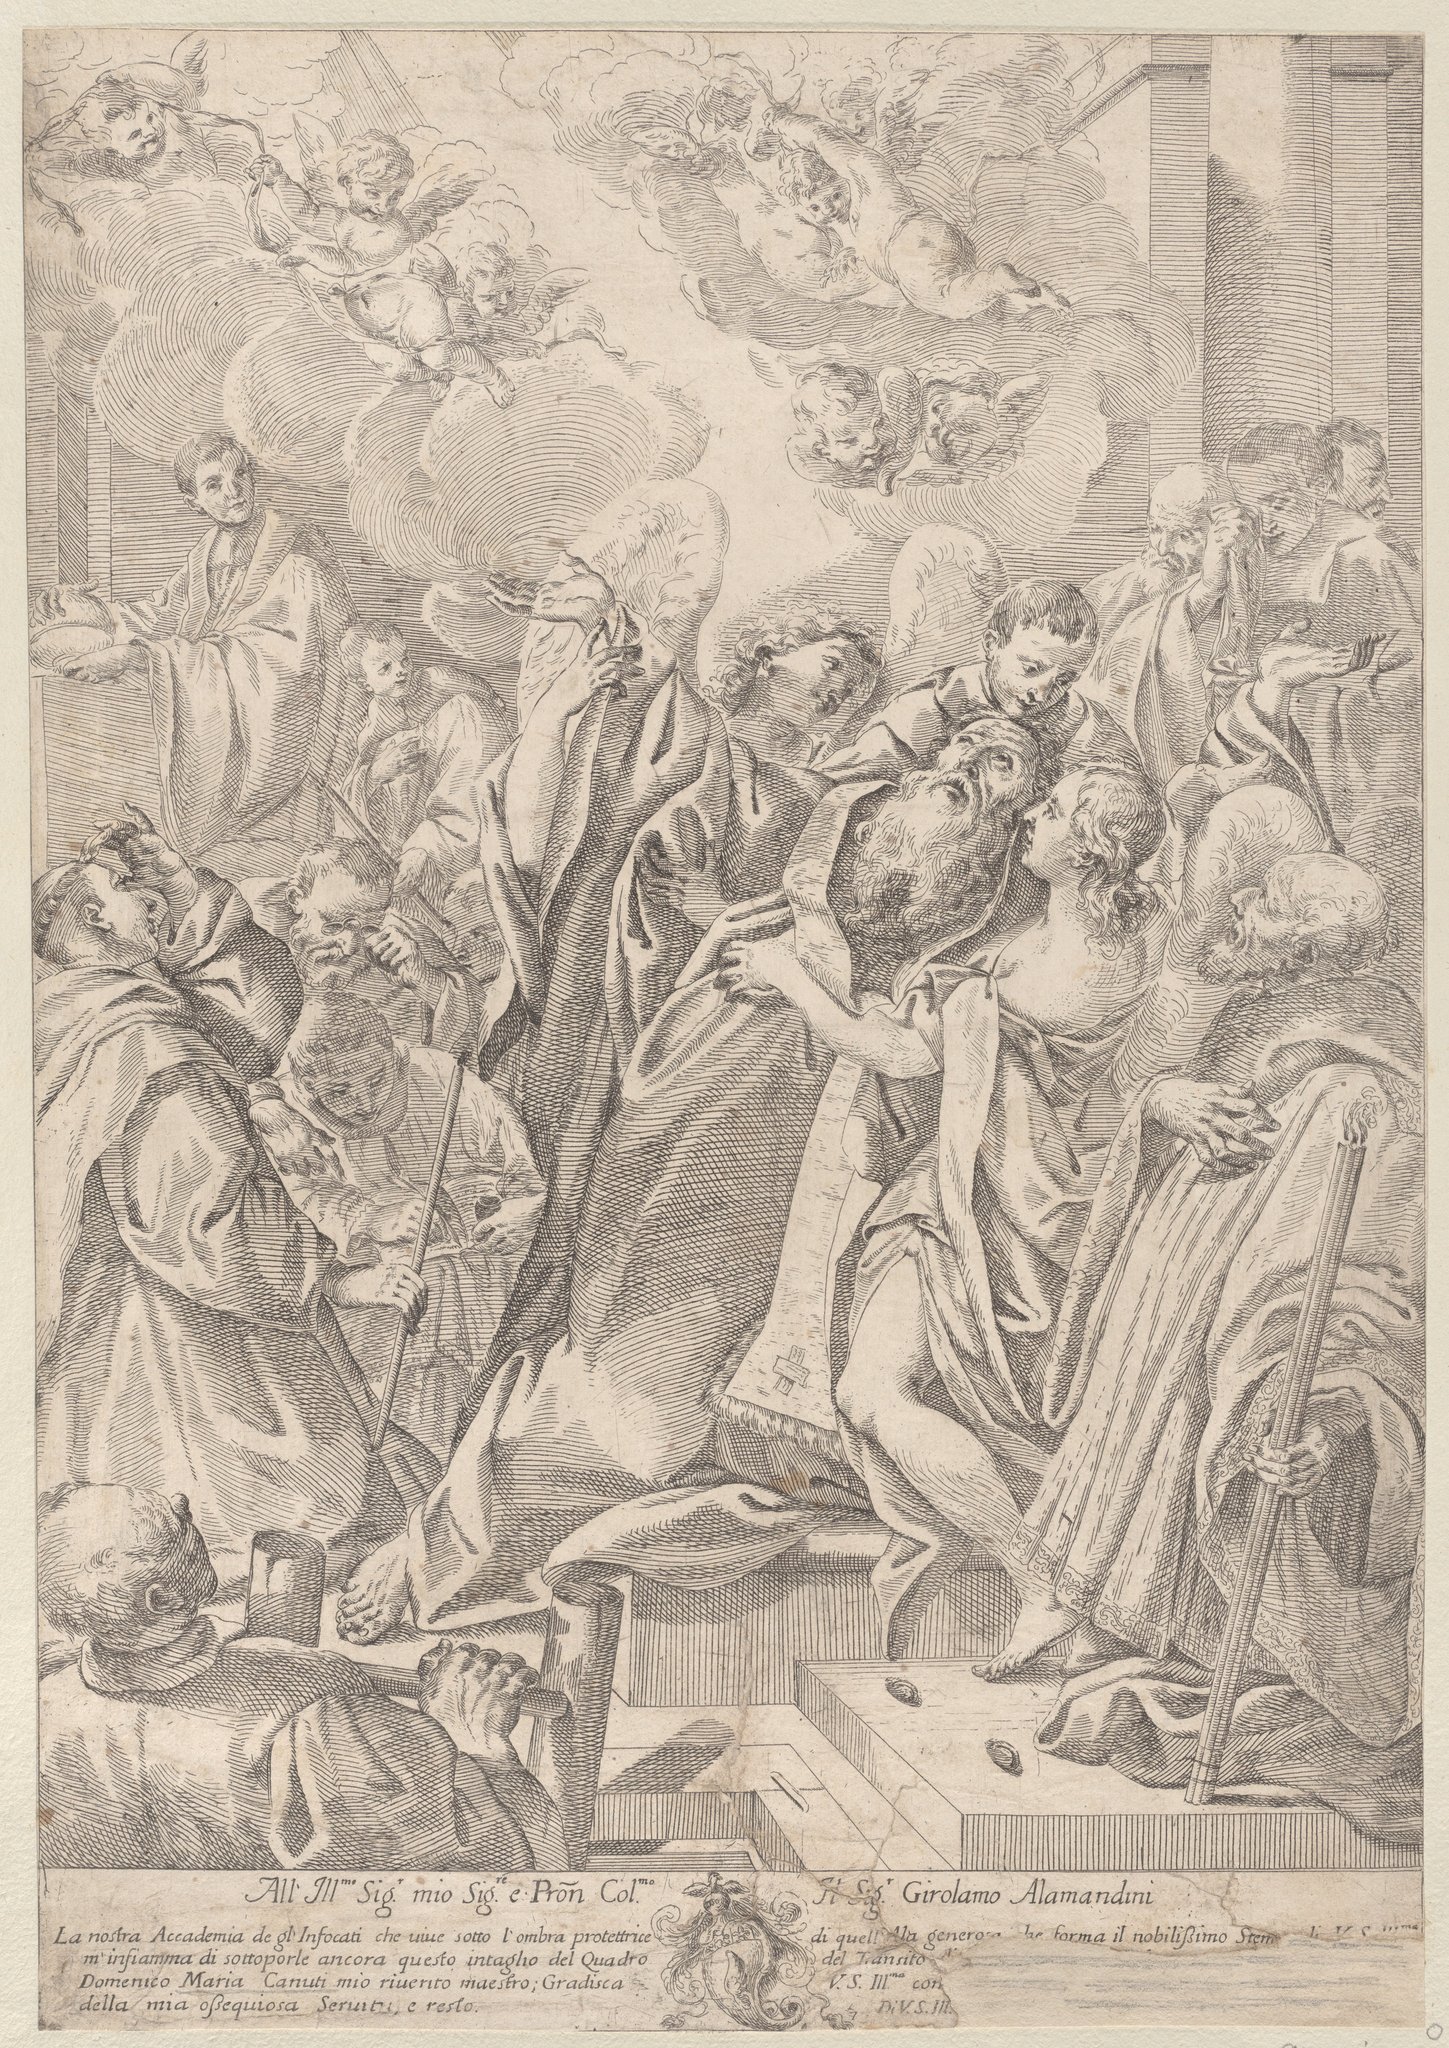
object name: print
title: A saint at right, Saint John Nepomuk (?), surrounded by figures, raising his hands towards angels at upper left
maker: Anonymous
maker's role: artist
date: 1670-1731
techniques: etching